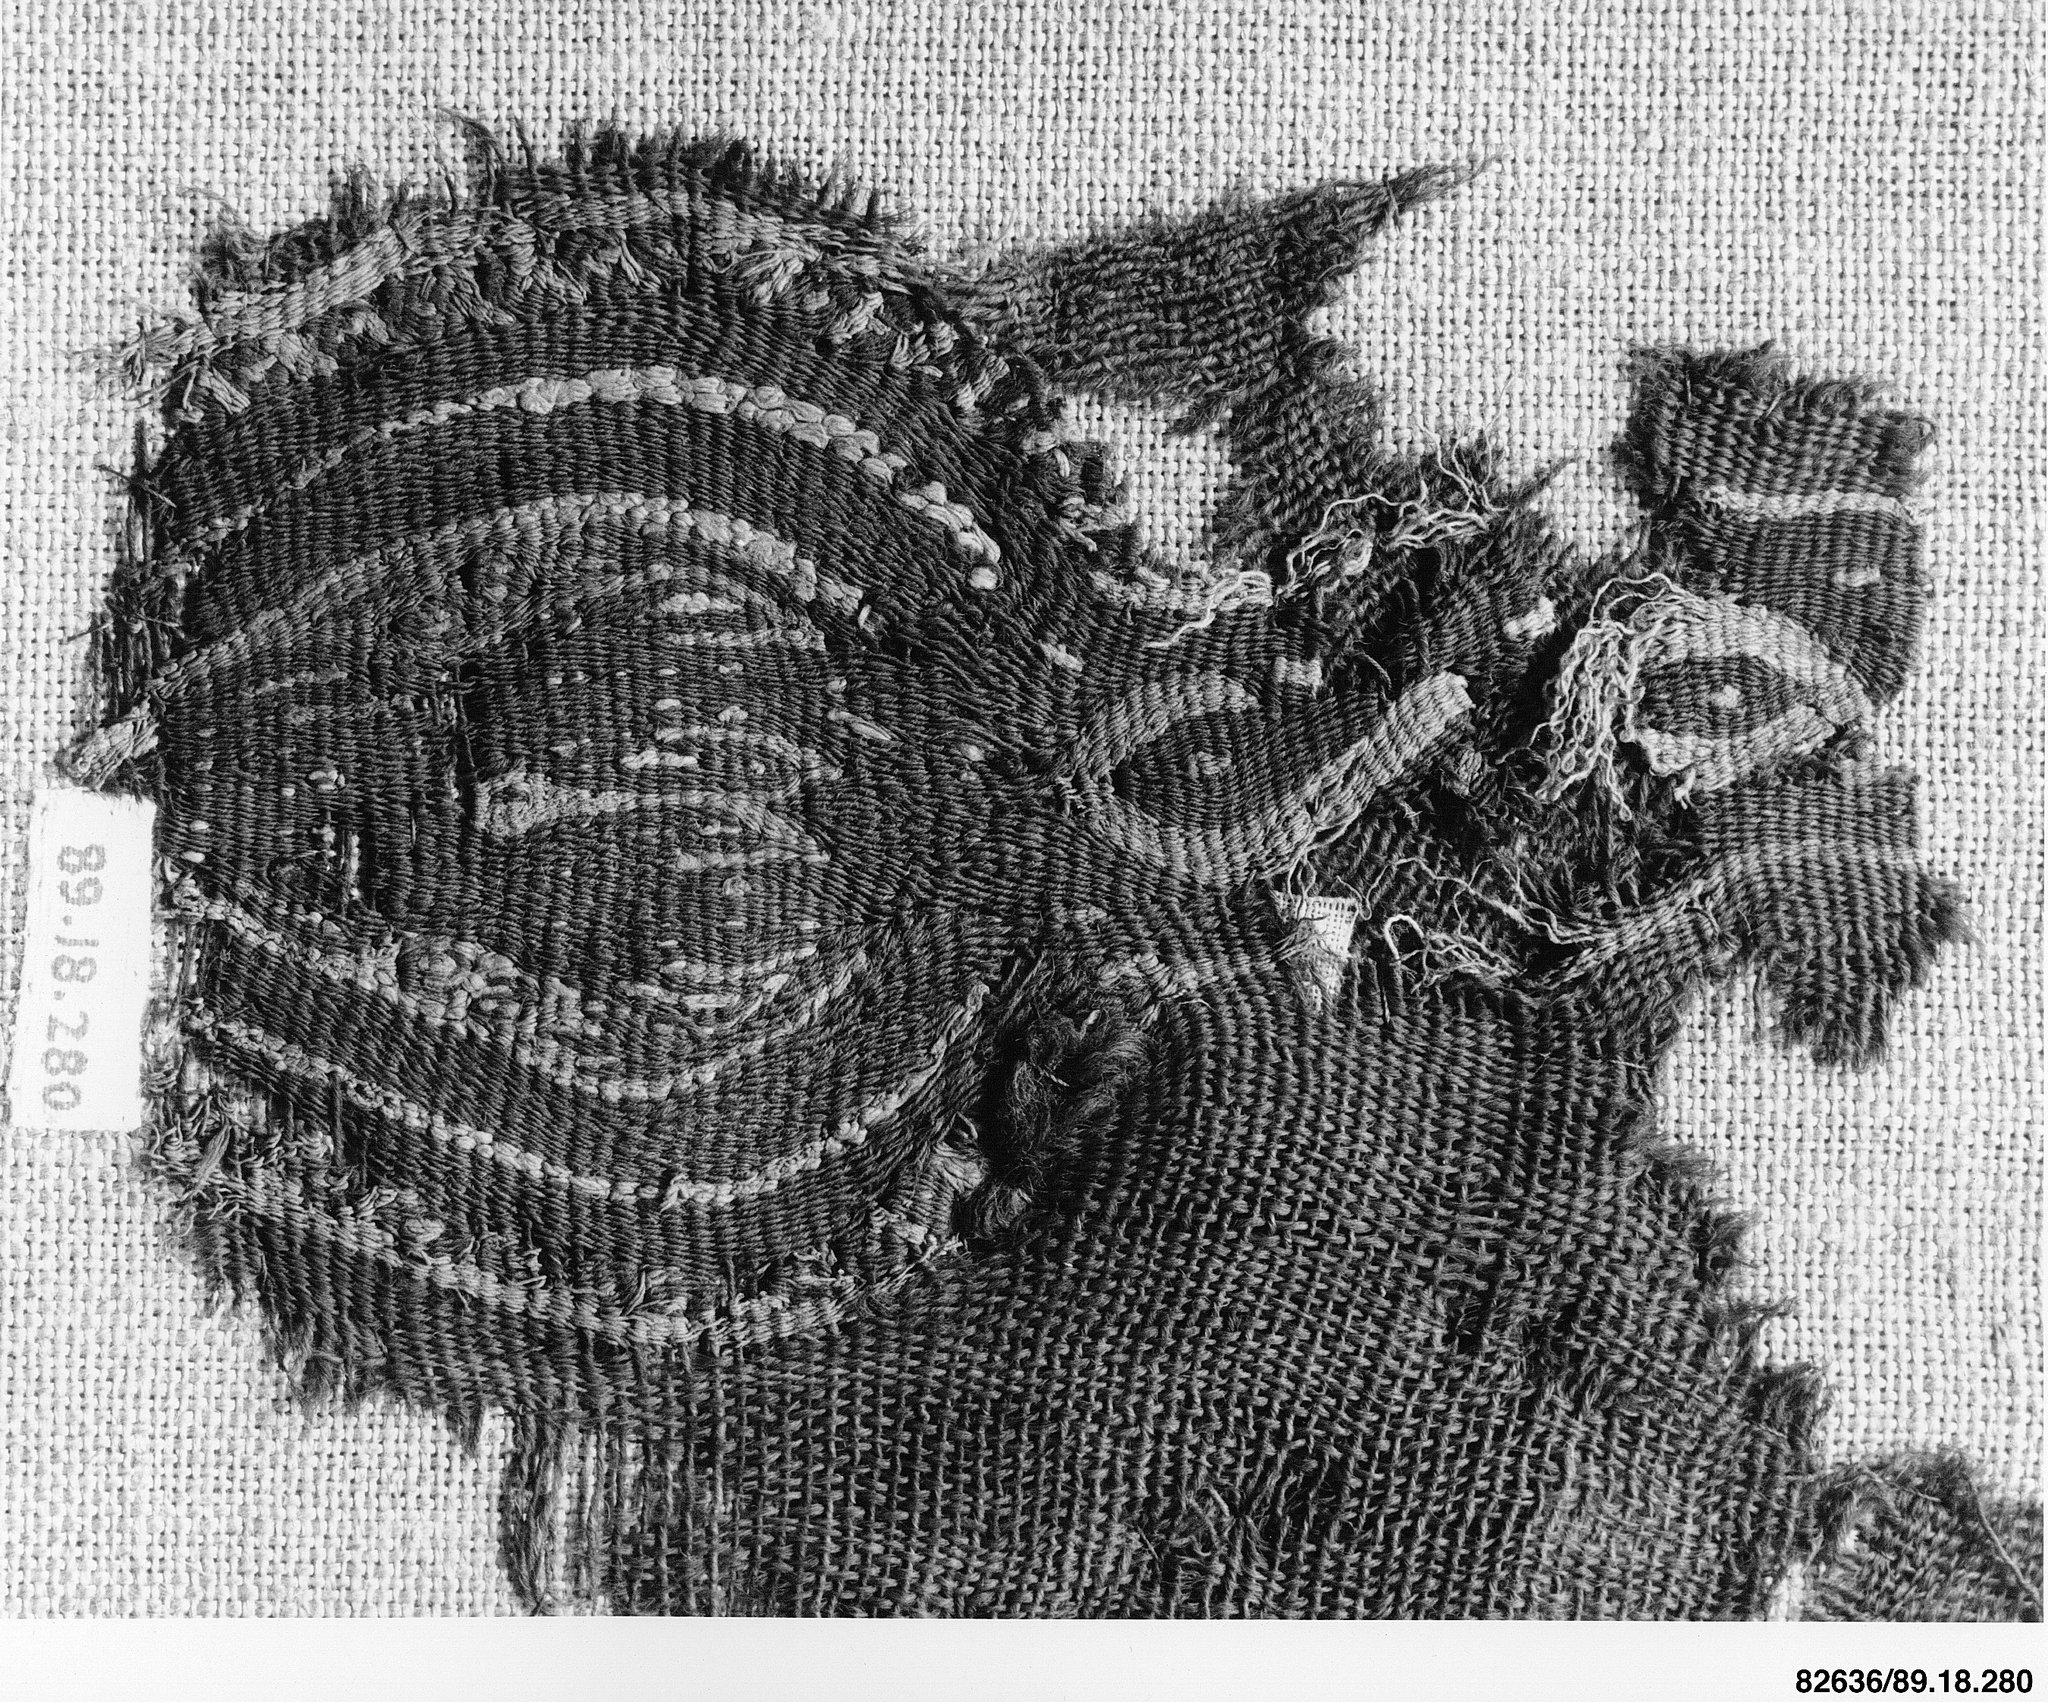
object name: textile fragment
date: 301-400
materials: linen, wool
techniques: weave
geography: egypt